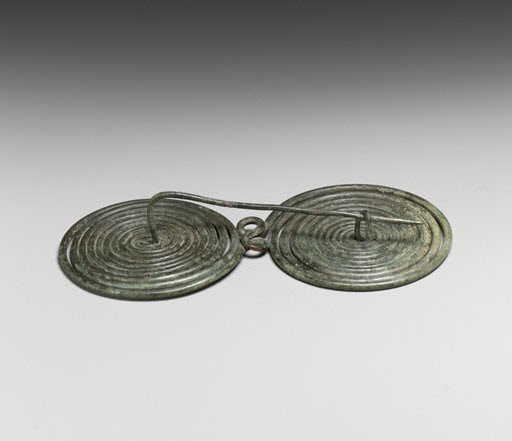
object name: fibula, spectacle type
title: Bronze spectacle fibula (safety pin)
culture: italic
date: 1000-601 BCE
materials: bronze